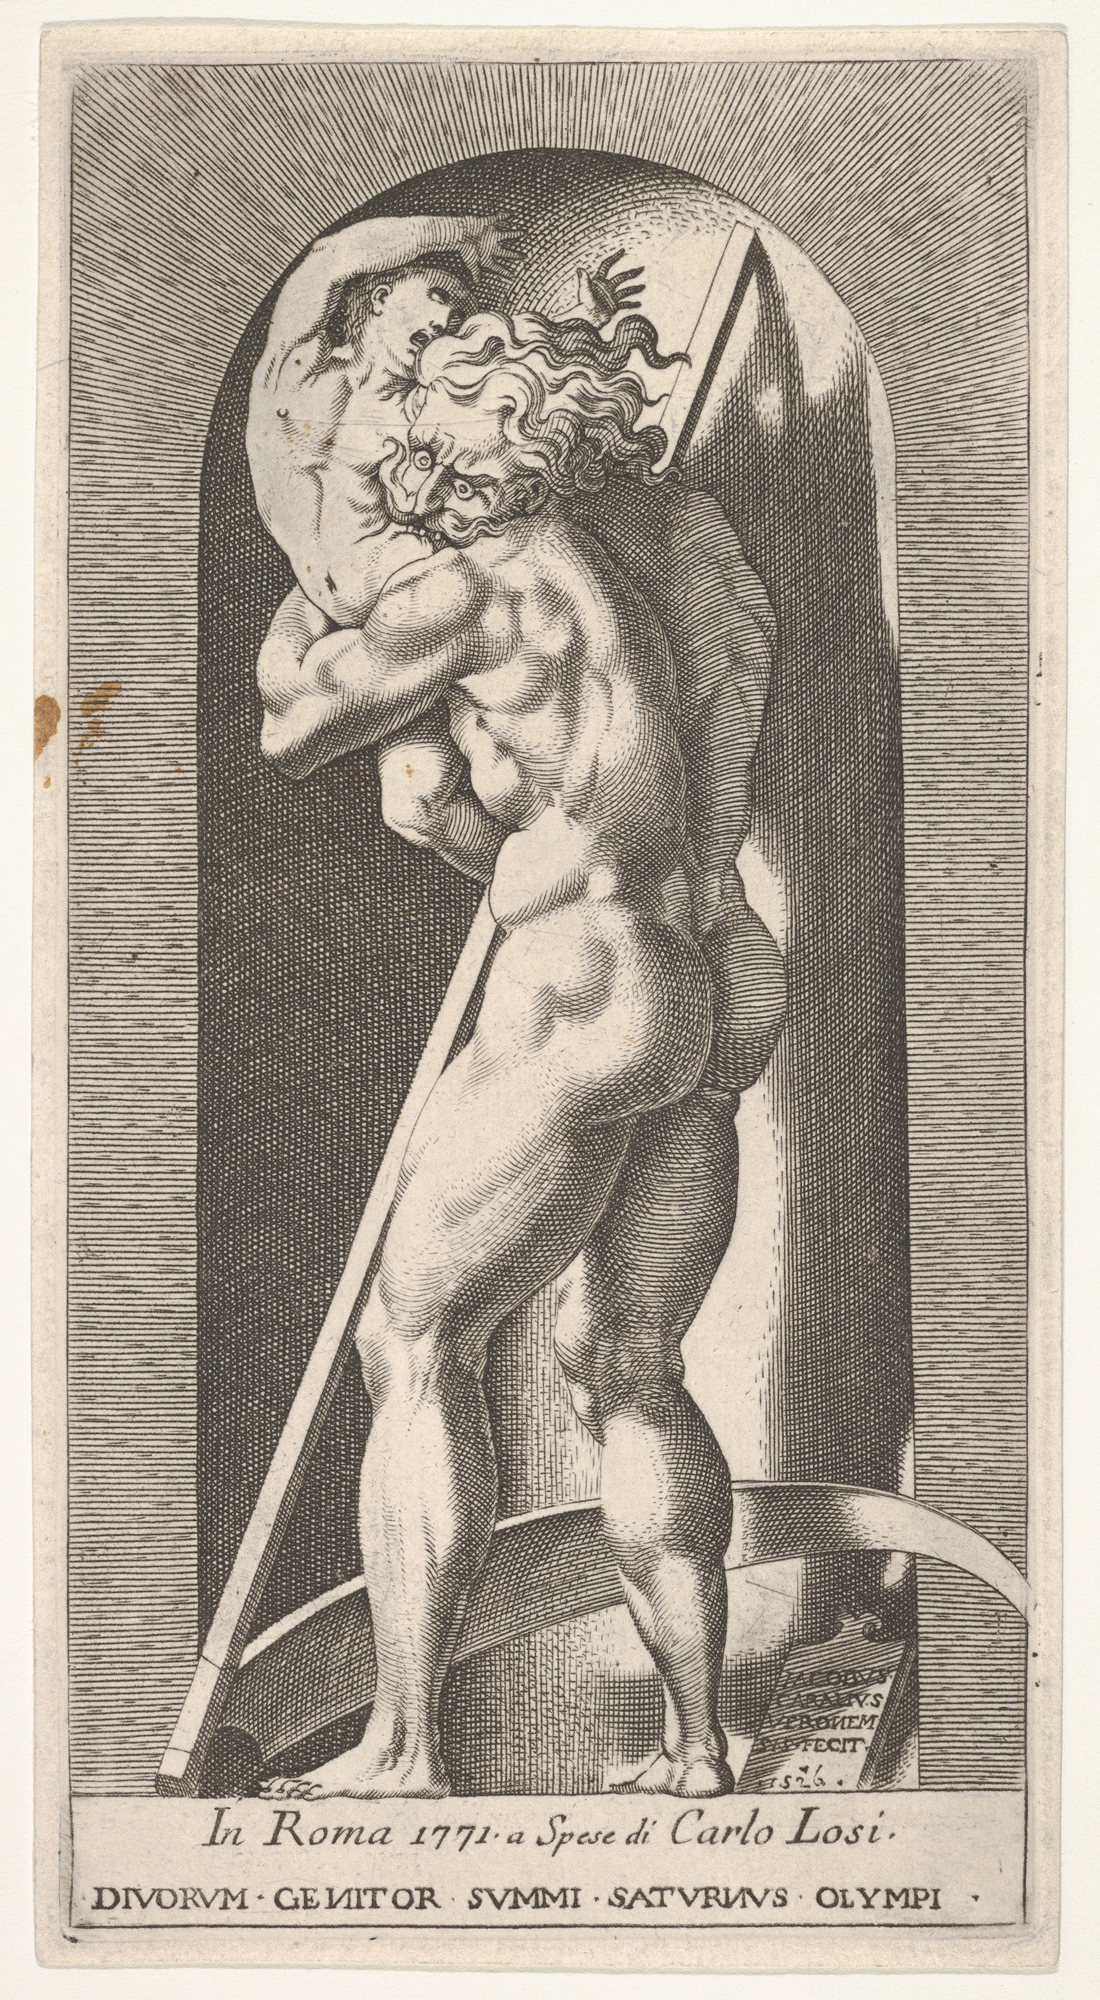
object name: print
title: Plate 1: Saturn in a niche devouring his son, standing before a scythe, from a series of mythological gods and goddesses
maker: giovanni jacopo caraglio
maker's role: artist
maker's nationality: italian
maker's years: 1500-1565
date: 1526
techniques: engraving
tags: weapons,saturn